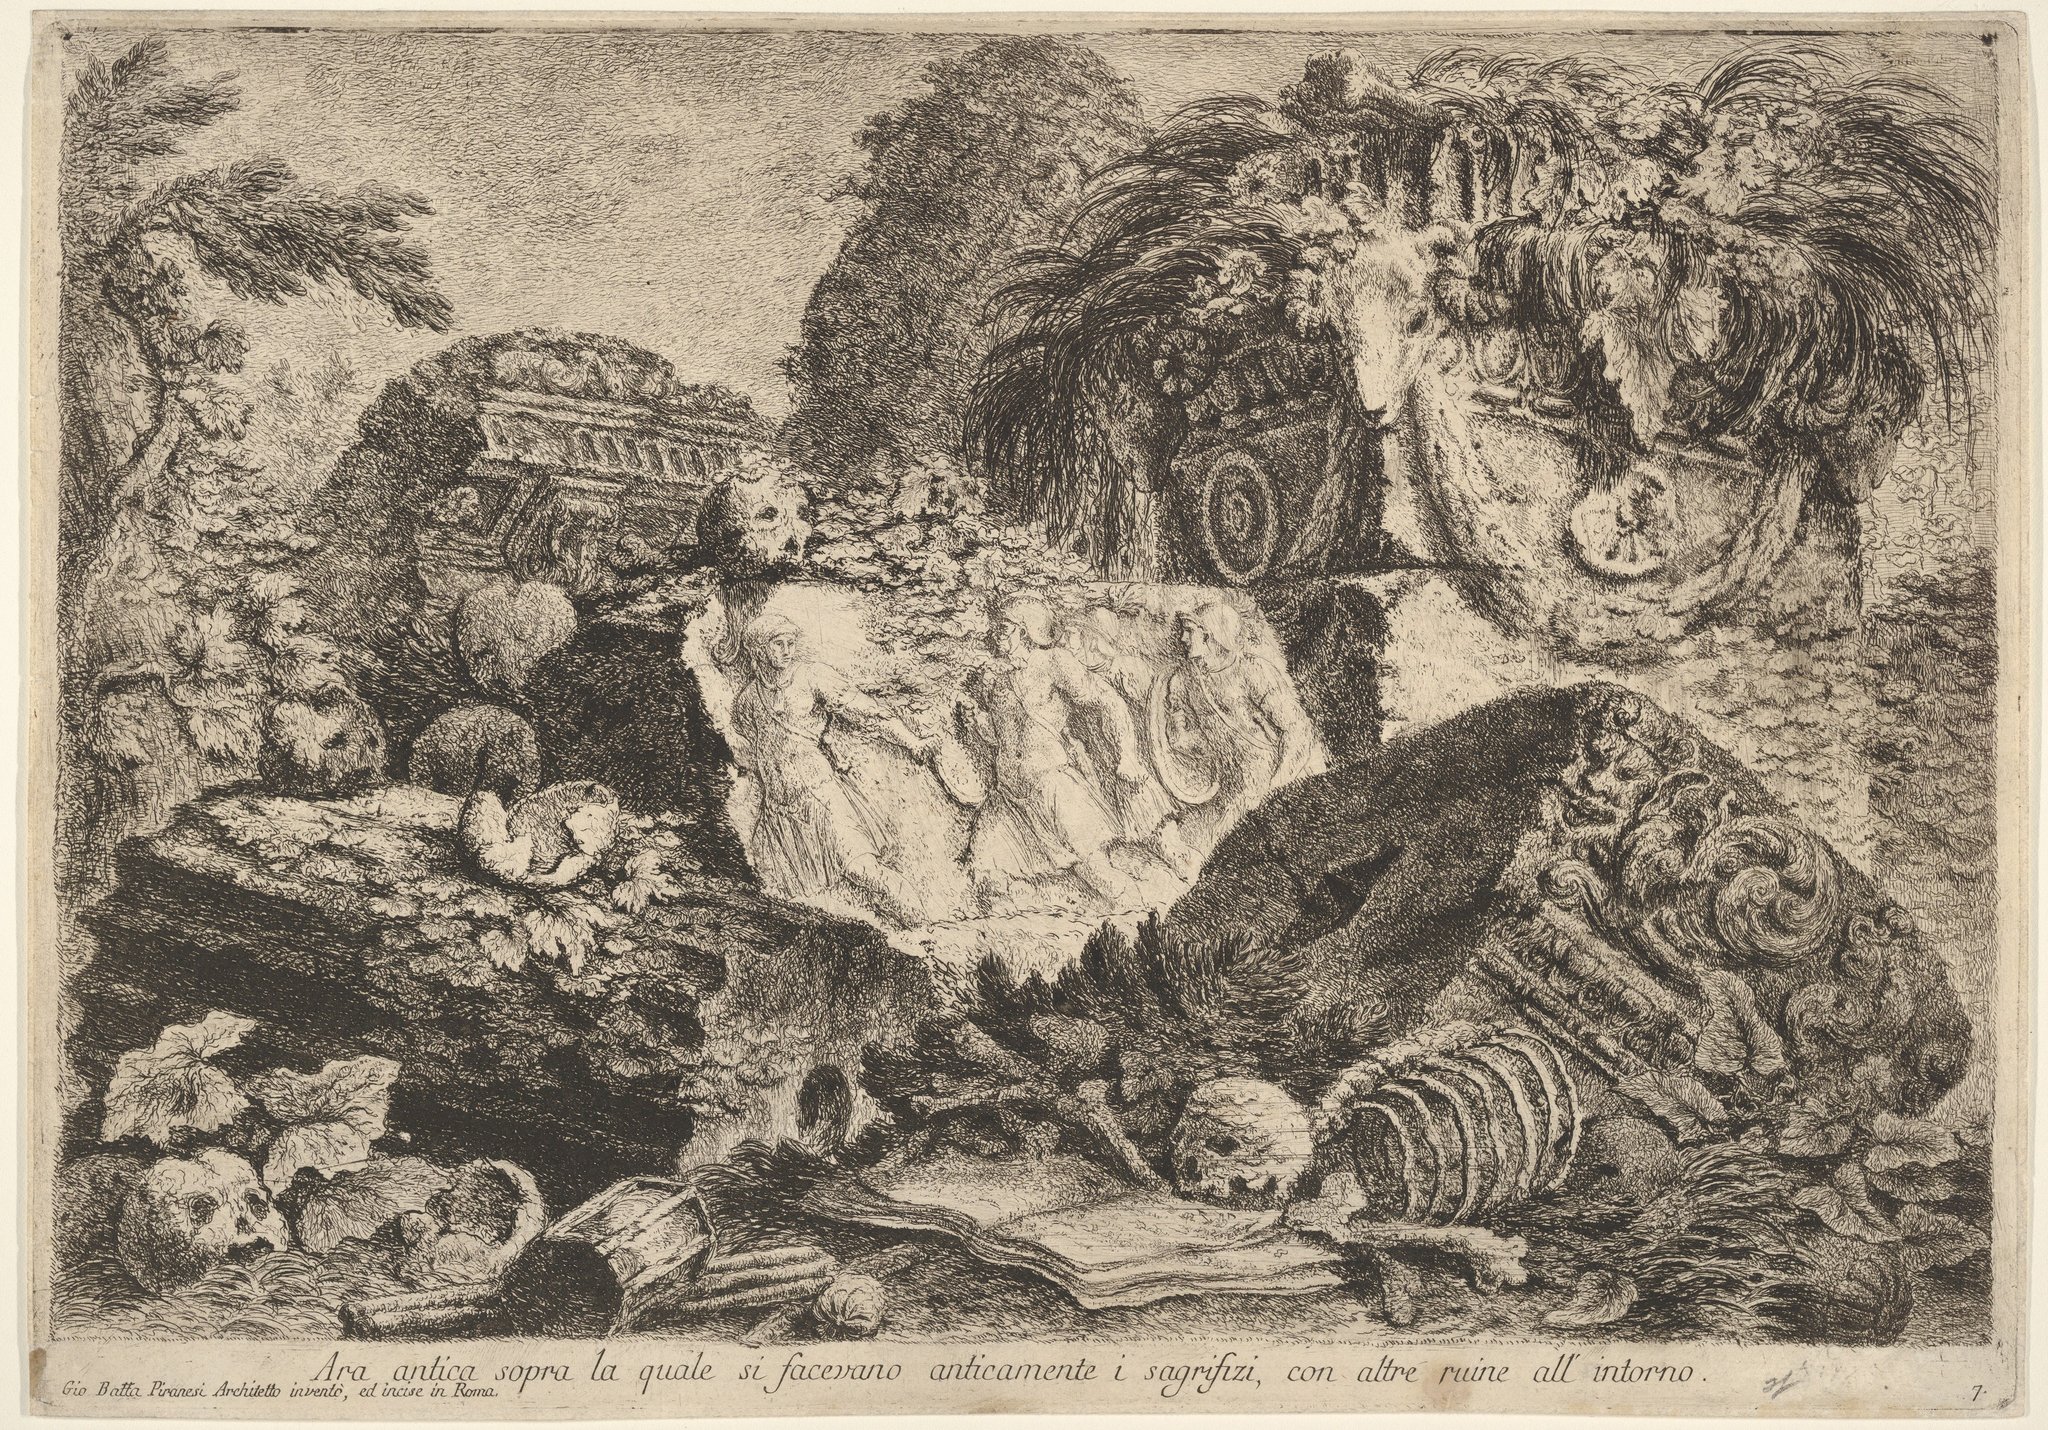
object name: print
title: Plate 7: Ancient altar on which sacrifices were performed in antiquity, surrounded by other ruins (Ara antica sopra la quale si facevano anticamente i sagrifizi, con altre ruine all' intorno), from "Part one of architecture and perspectives: drawn and etched by Gio. Batt'a Piranesi, Venetian Architect: dedicated to Nicola Giobbe" (Prima parte di Architetture, e prospettive inventate, ed incise da Gio. Batt'a Piranesi Architetto Veneziano dedicate al Sig. Nicola Giobbe)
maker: giovanni battista piranesi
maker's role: artist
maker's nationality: italian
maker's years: 1720-1778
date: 1743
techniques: etching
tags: altars,ruins,garlands,skulls,men